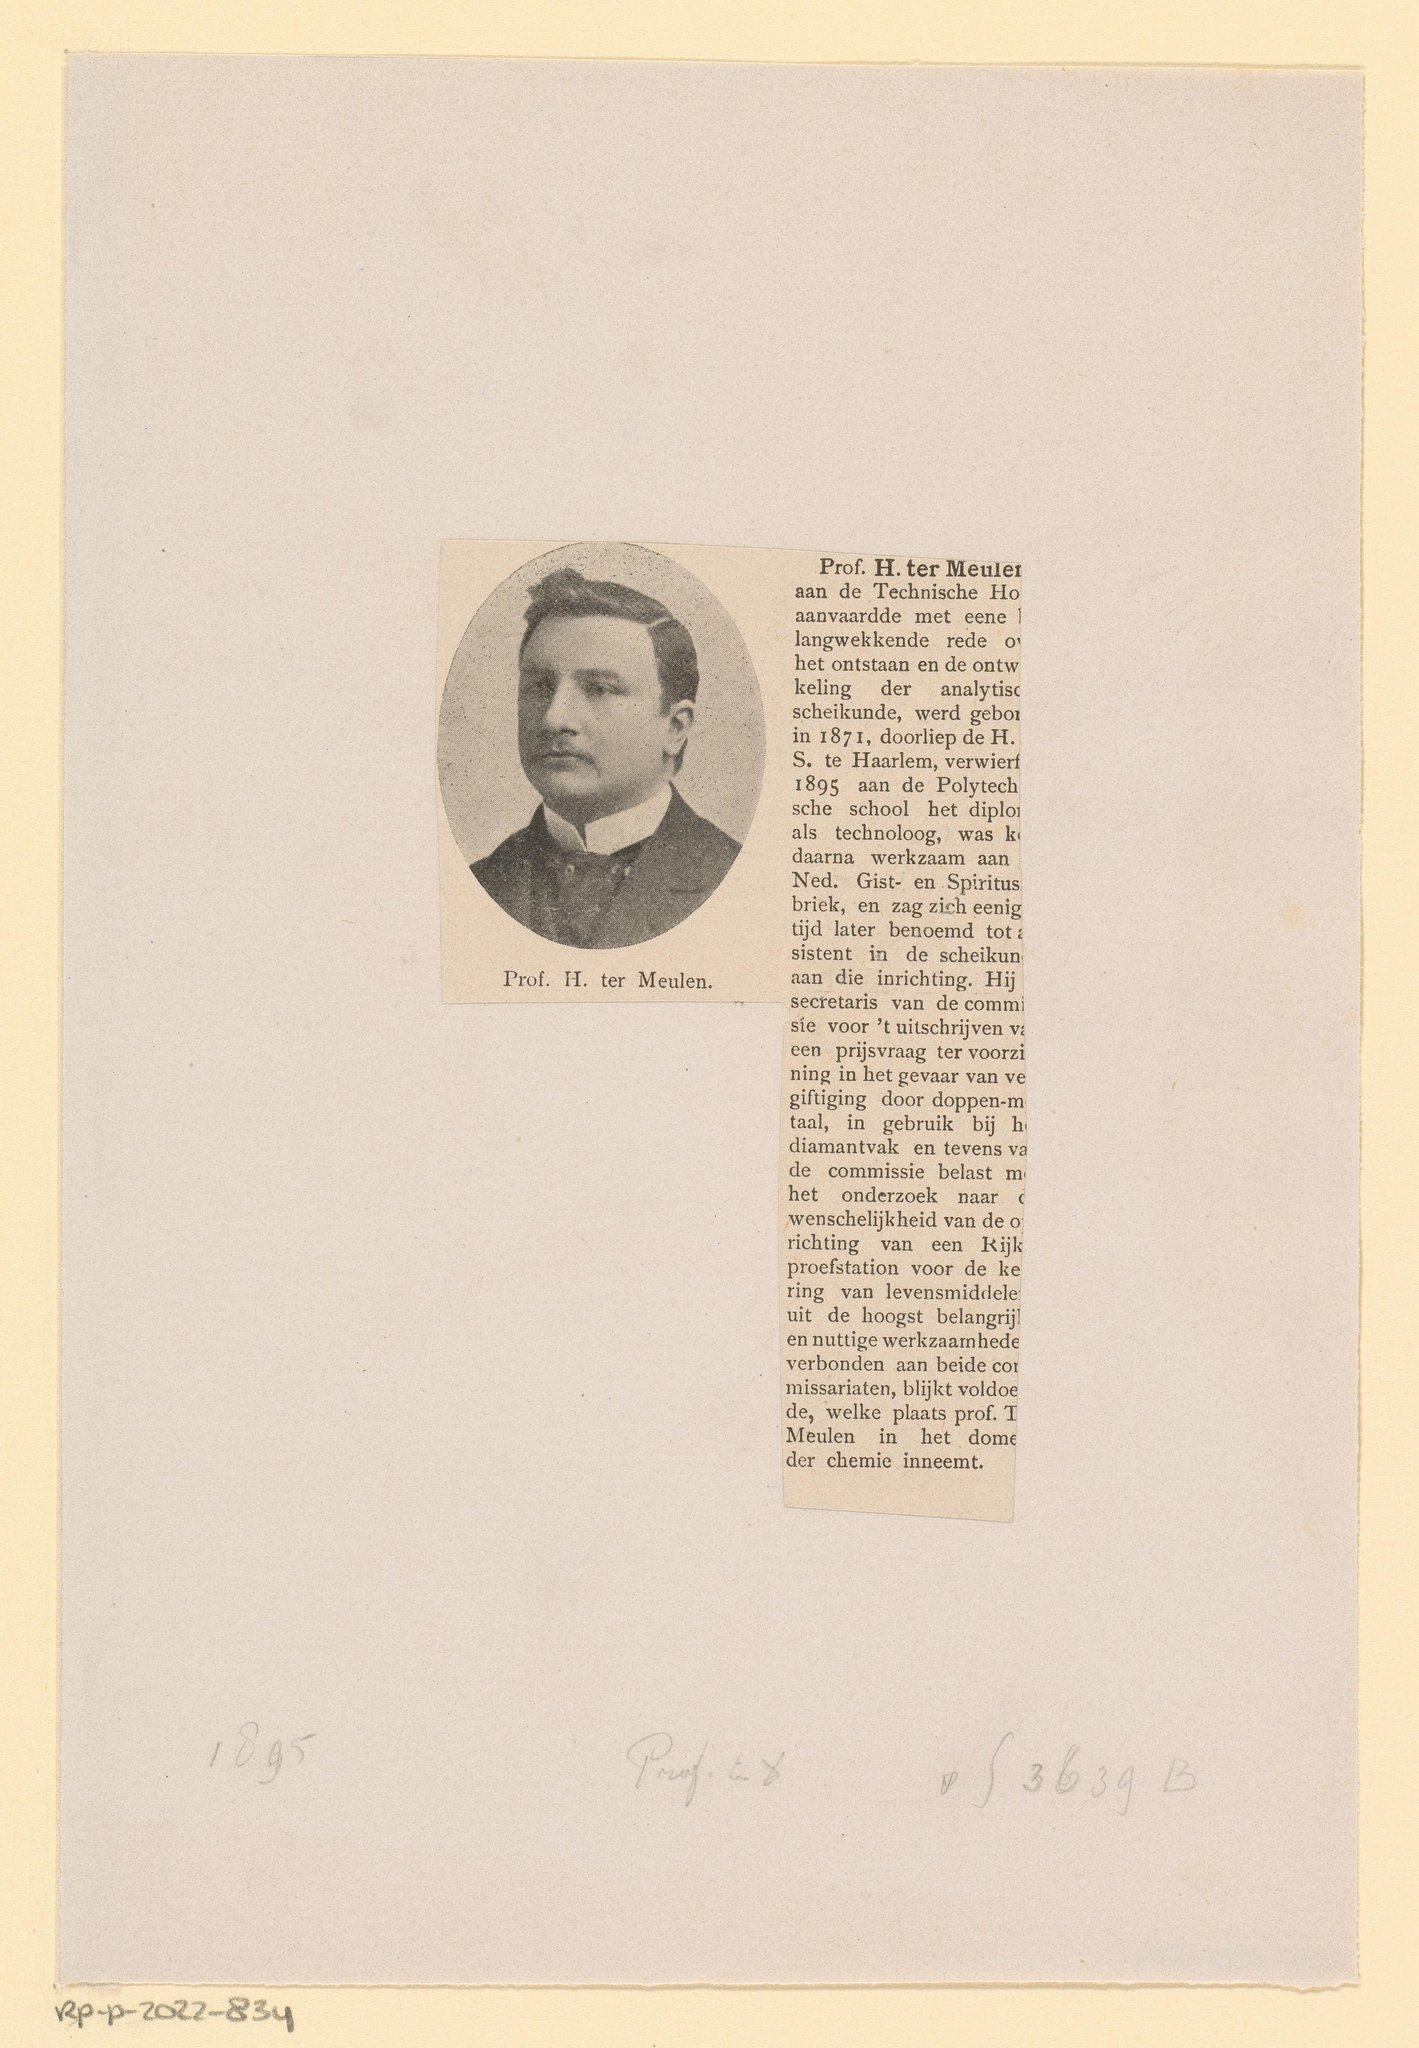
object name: photomechanical print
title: Portret van Henri ter Meulen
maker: Anonymous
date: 1905-1942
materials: paper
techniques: letterpress printing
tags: amsterdam, the hague, pharmacist, druggist, apothecary; pharmacy, drugstore, dispensing chemist, historical persons